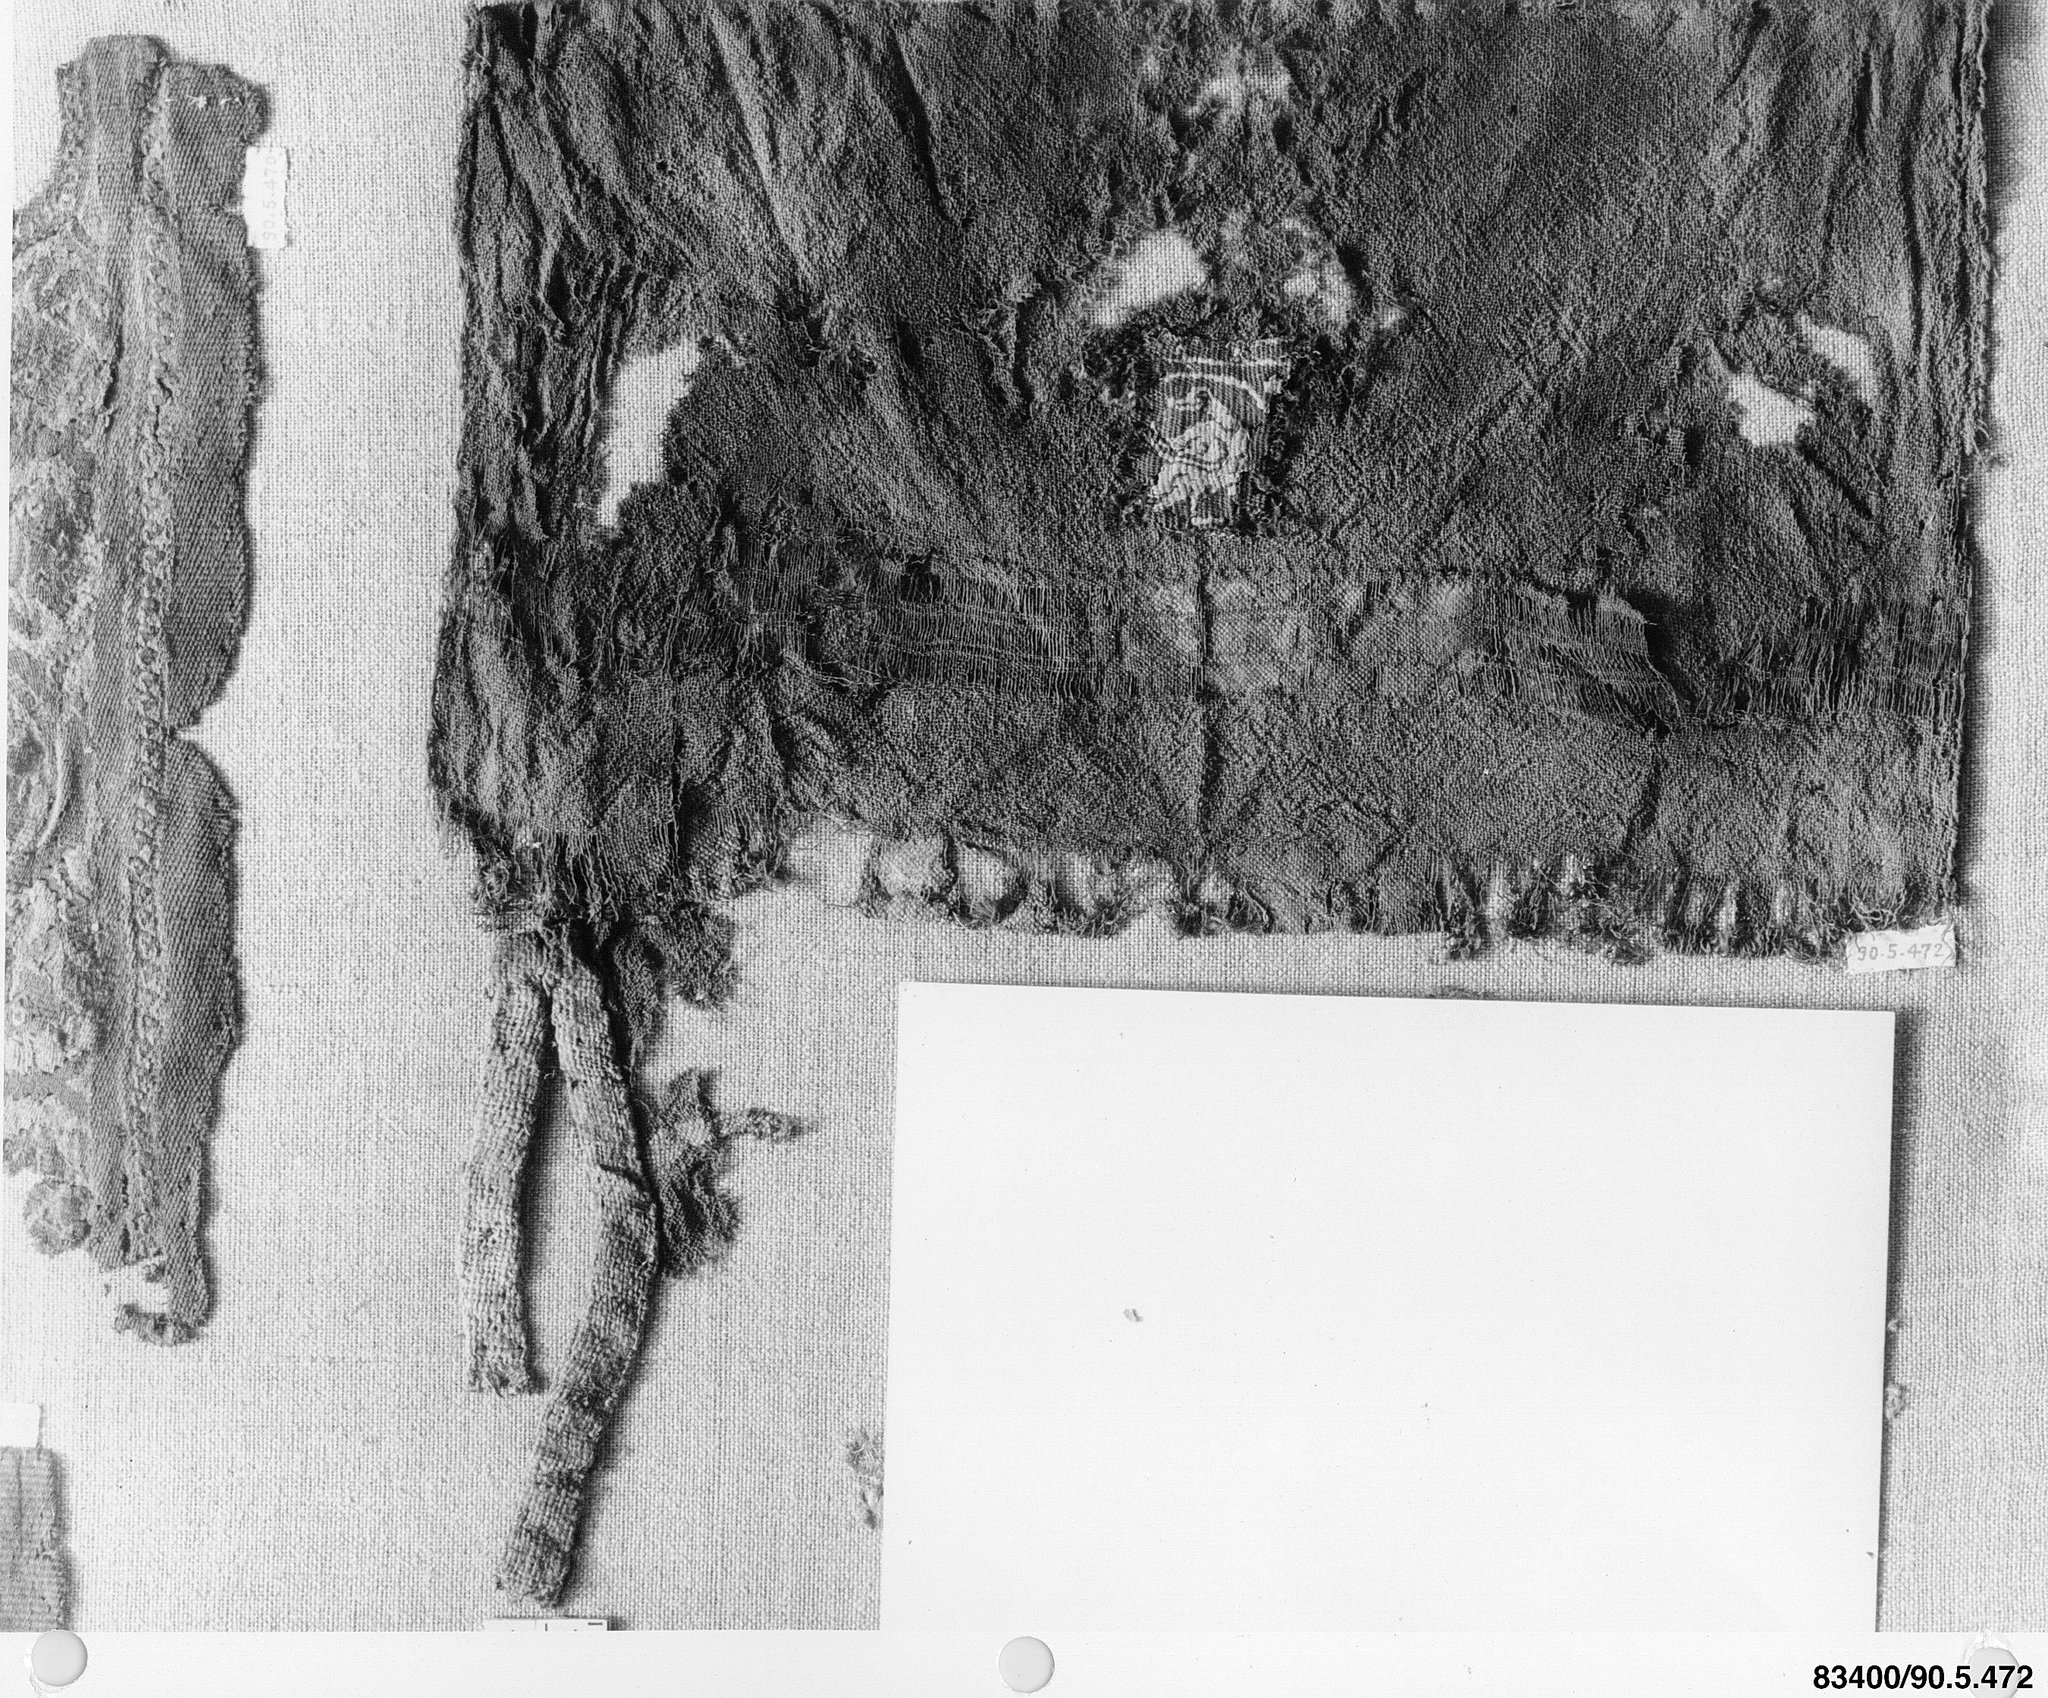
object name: textile fragment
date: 301-400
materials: linen, wool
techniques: weave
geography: egypt